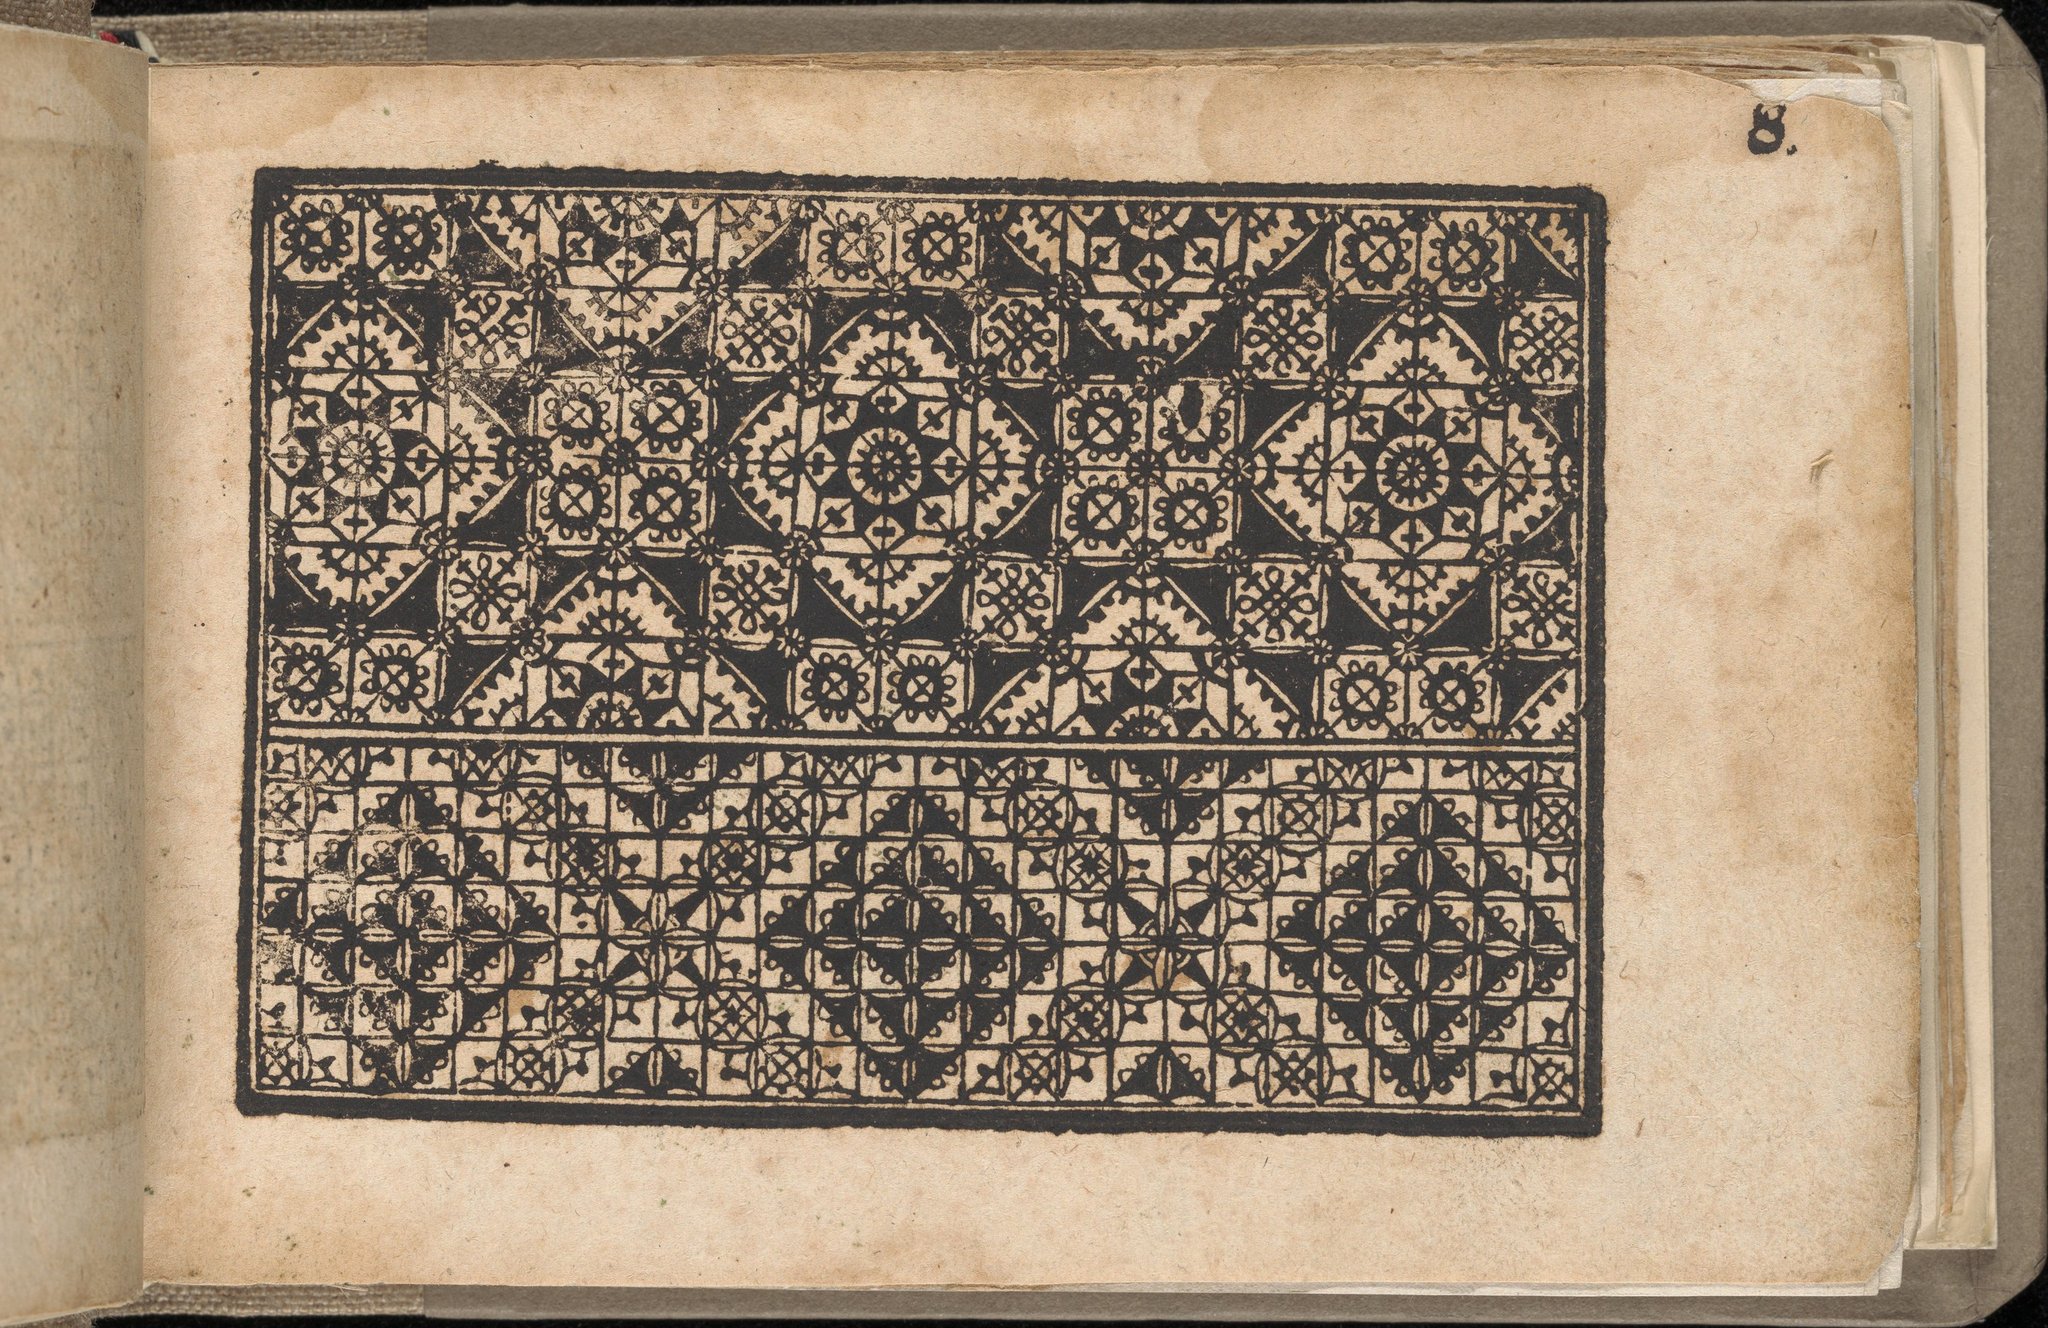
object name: book print ornament architecture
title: Schön newes Modelbuch (Page 8r)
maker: sigismundus latomus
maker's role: publisher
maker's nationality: german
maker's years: 1599-1632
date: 1608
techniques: woodcut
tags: ornament